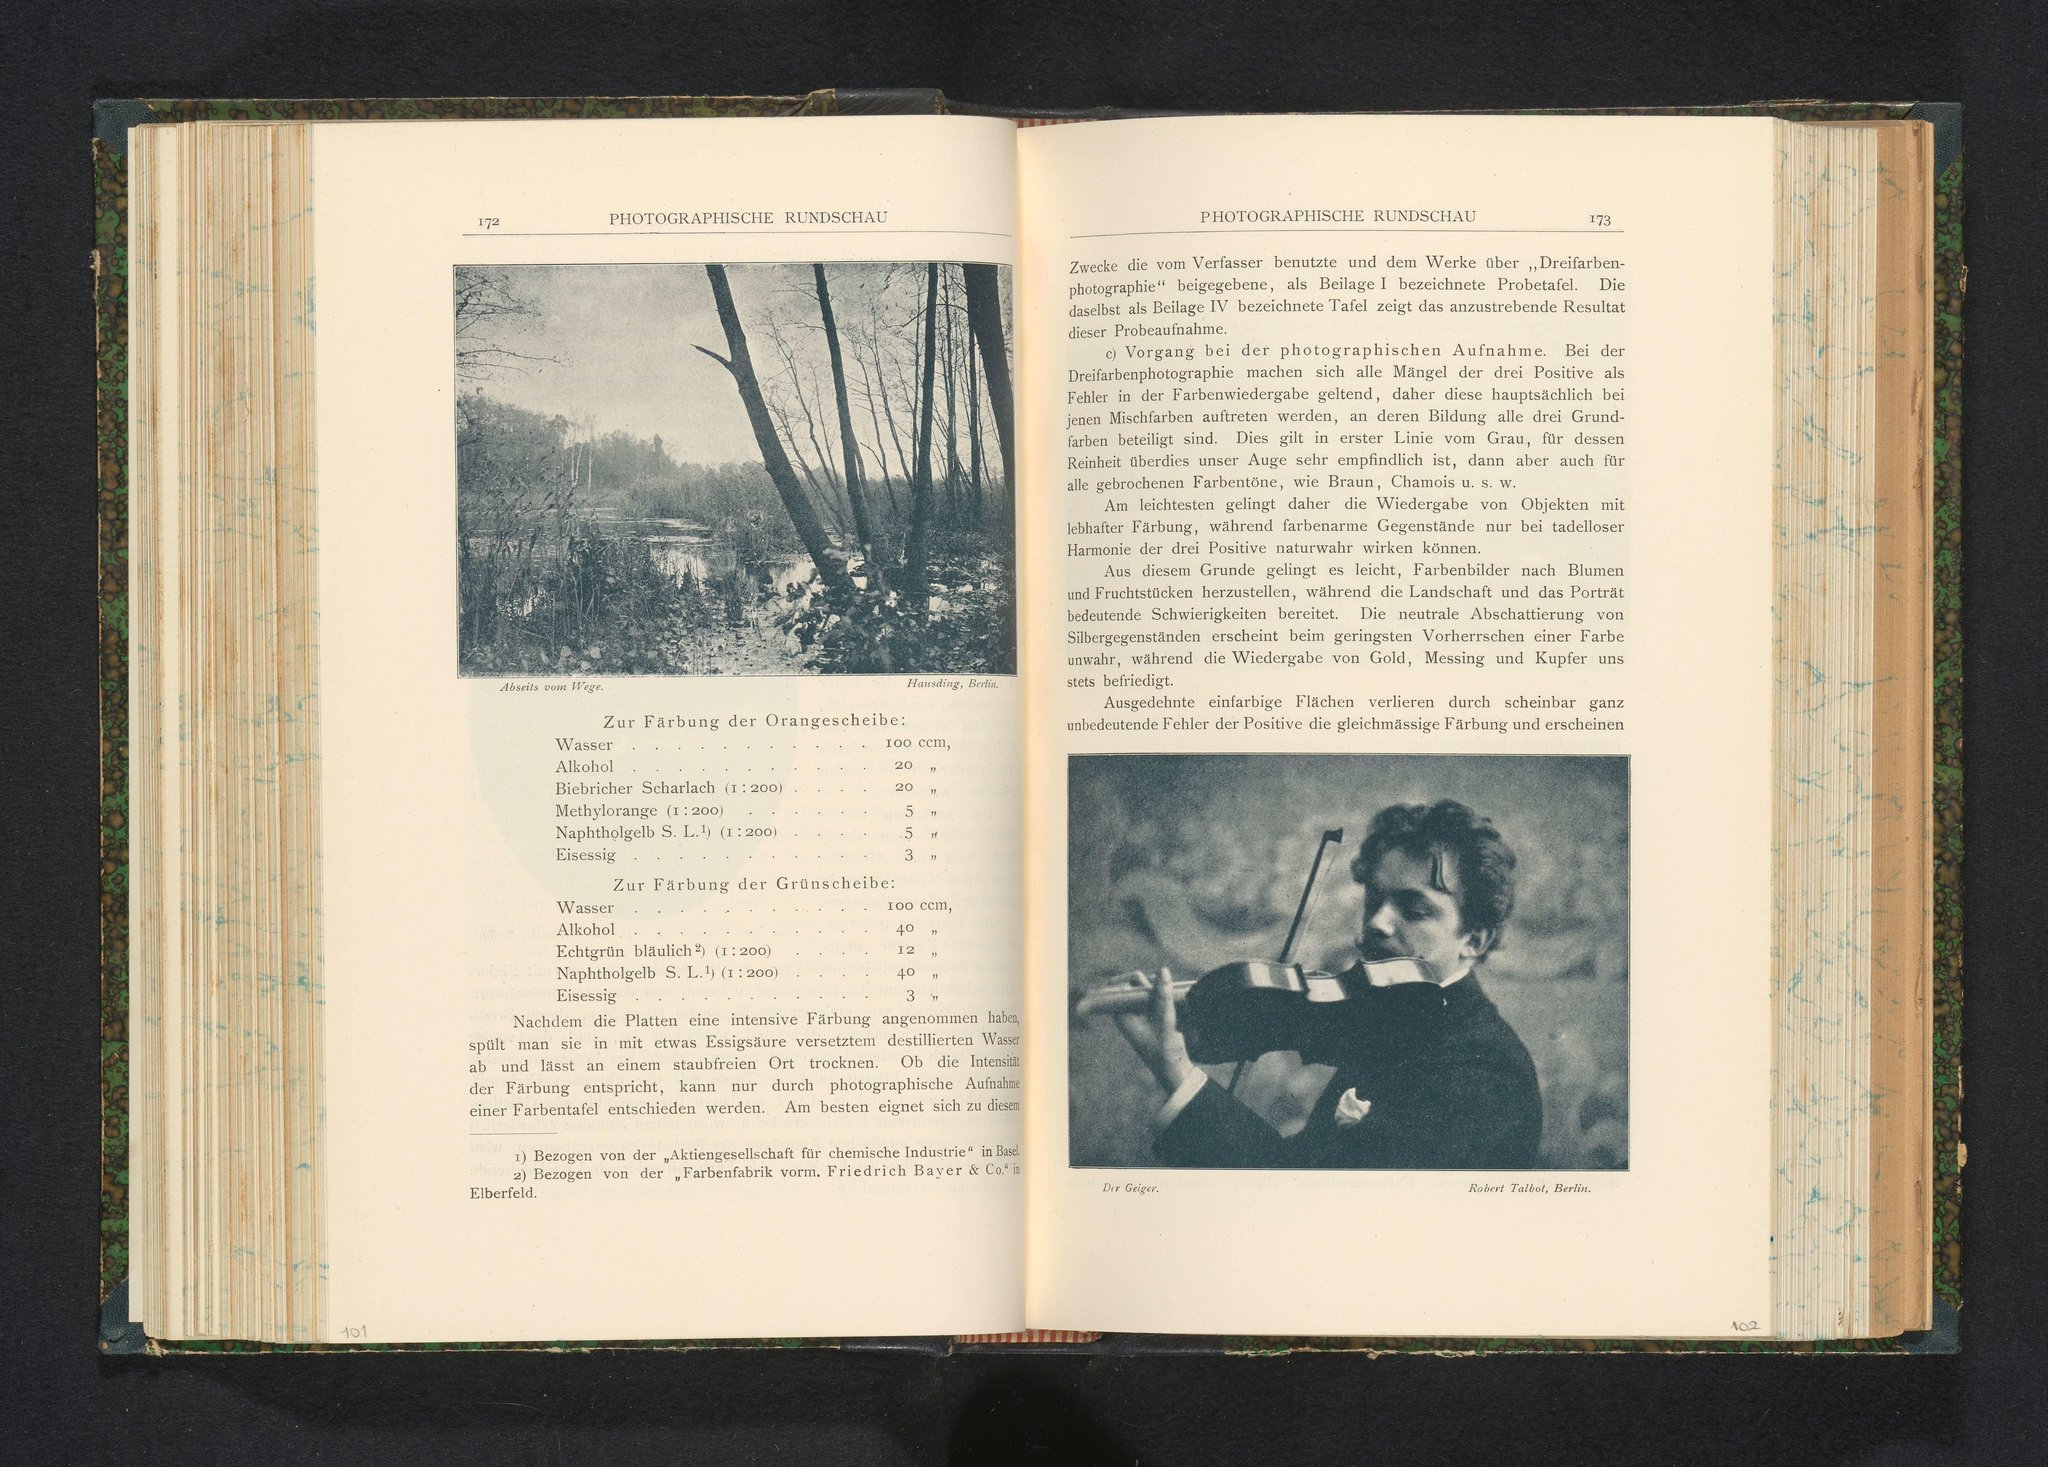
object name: page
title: Portret van een onbekende violist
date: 1894-1899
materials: paper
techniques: autotype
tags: violin, fiddle, historical persons not known by name